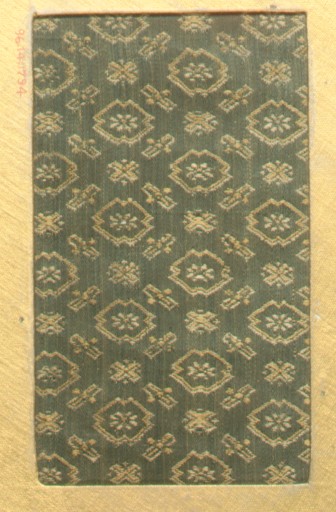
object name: piece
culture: japanese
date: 1701-1900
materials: silk